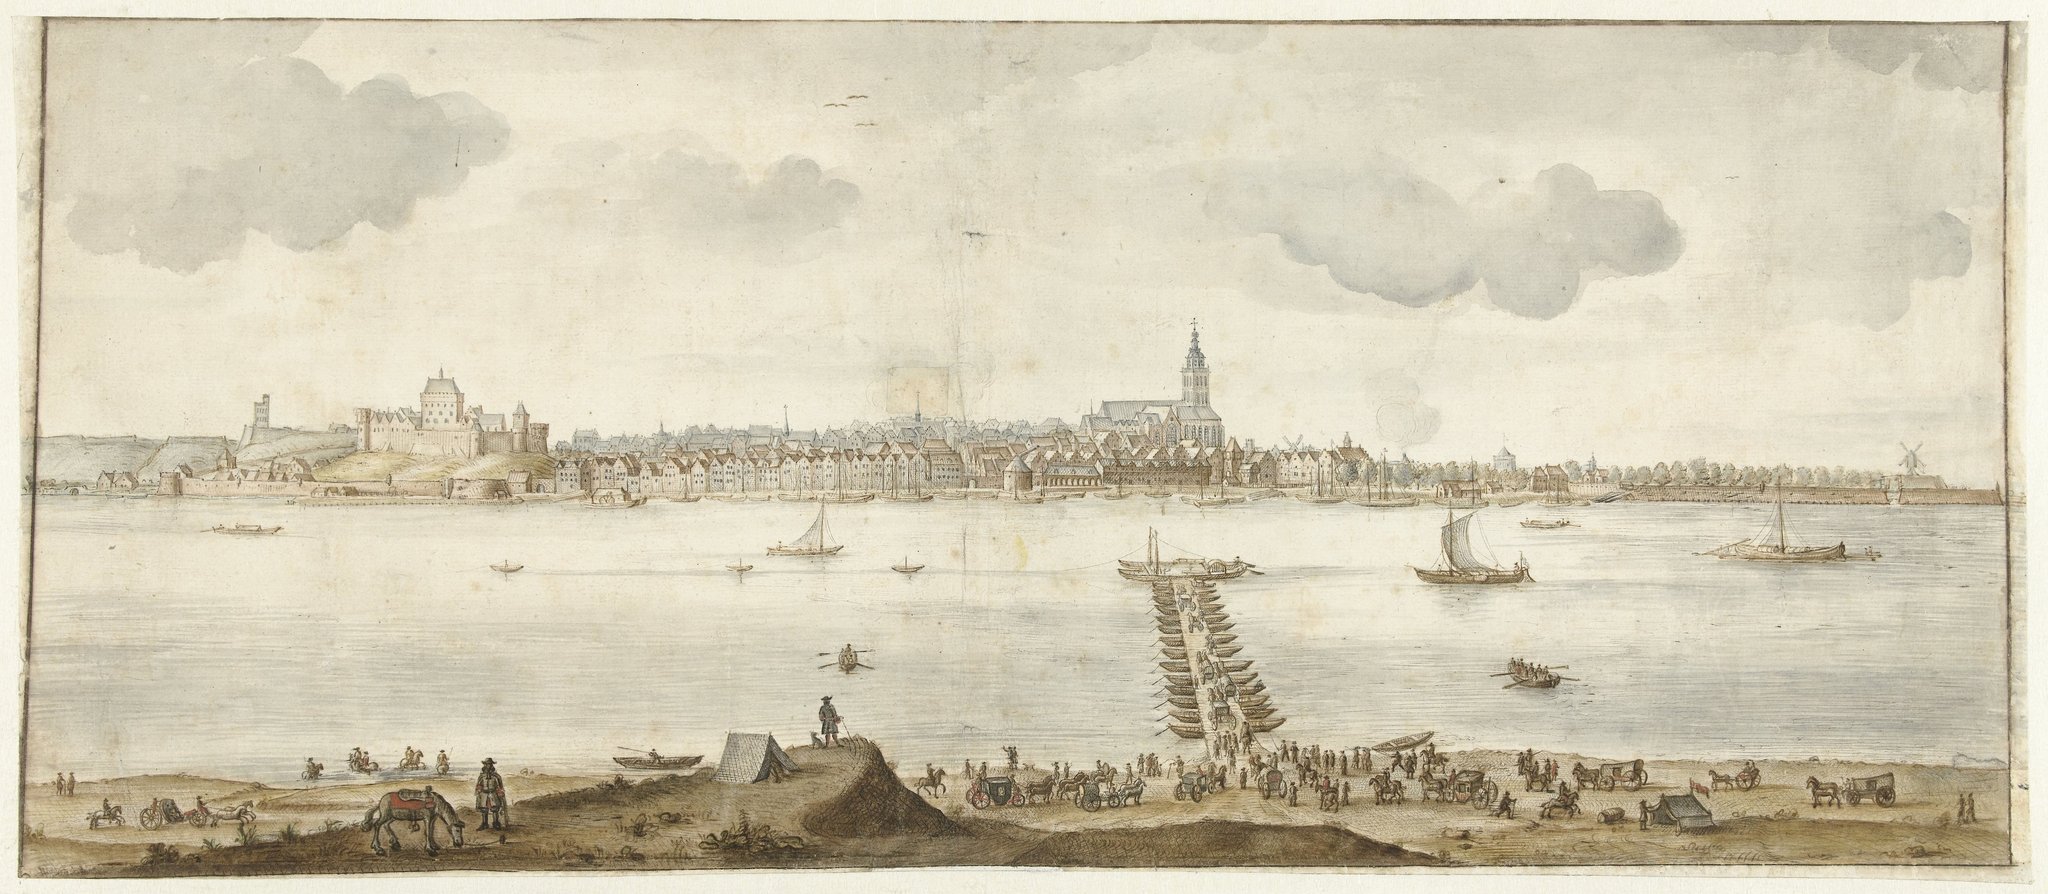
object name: drawing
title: Gezicht op Nijmegen vanover de Waal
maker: Anonymous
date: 1600-1699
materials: ink, paper, watercolor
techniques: brush, pen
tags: pontoon bridge, prospect of city, town panorama, silhouette of city, nijmegen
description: Gezicht op Nijmegen vanover de Waal met een pontonbrug tot halverwege de rivier.